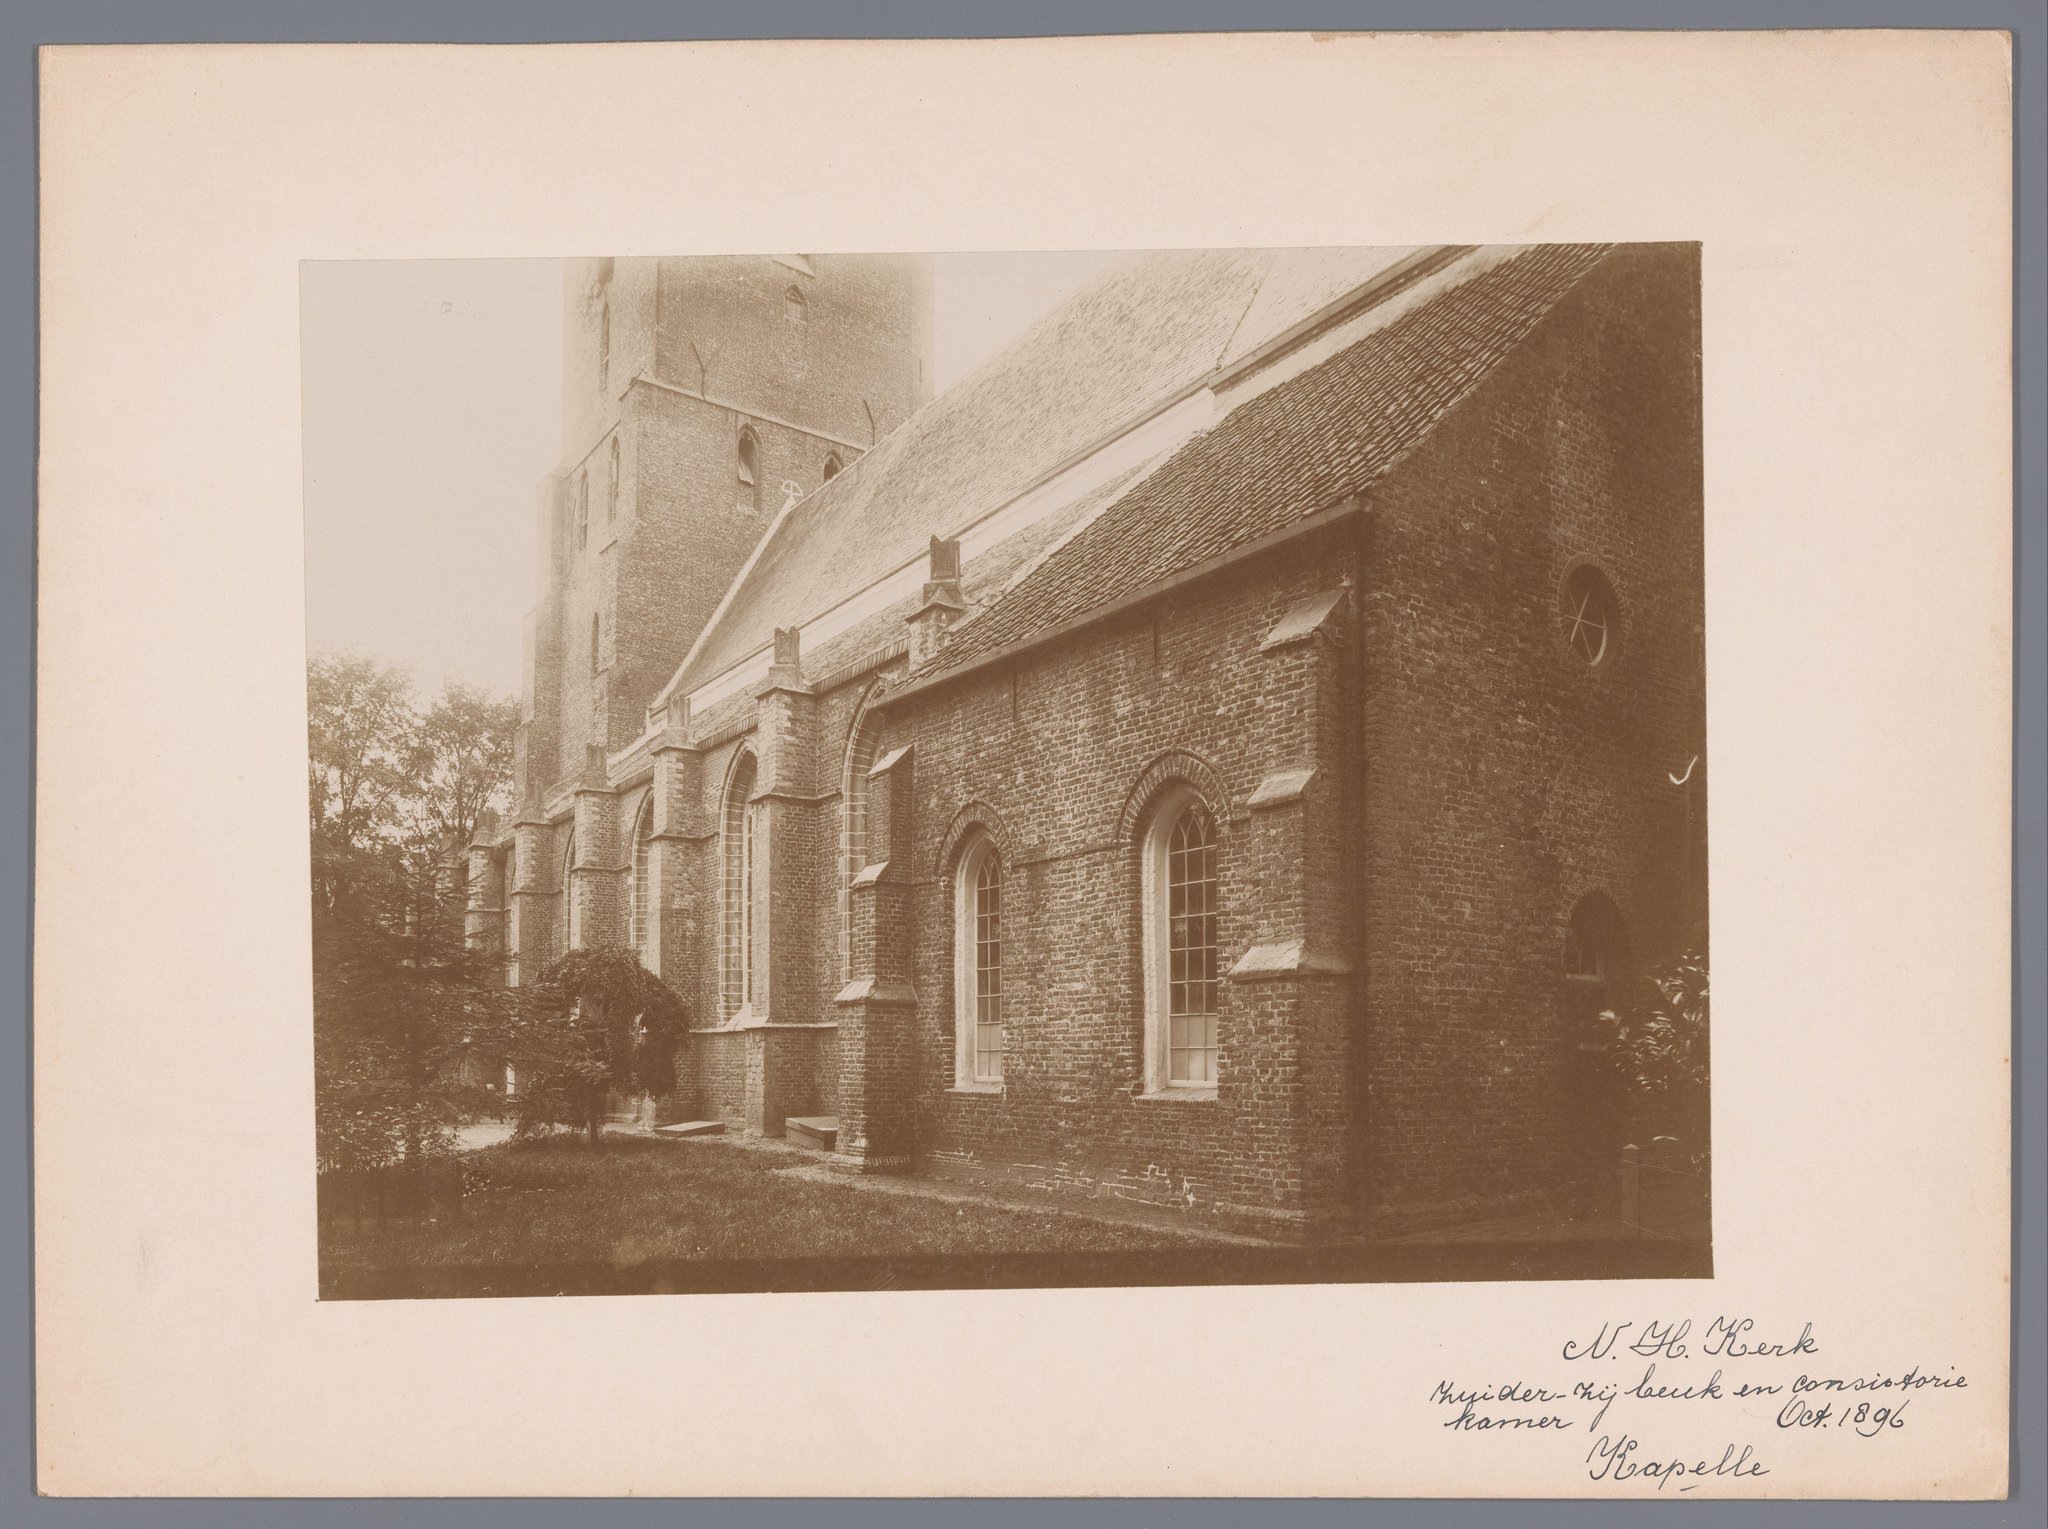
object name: photograph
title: Zuidzijde van de Hervormde Kerk te Kapelle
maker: anoniem (monumentenzorg)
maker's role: fotograaf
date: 1896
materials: cardboard, photographic support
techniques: collodion silver print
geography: kapelle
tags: church (exterior)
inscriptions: annotation: ‘N.H. Kerk/ zuider-zij beuk en consistorie kamer Oct. 1896/ Kapelle’, annotation: ‘Kapelle Z.B. (Zeeland)/ Zuiderzijbeuk en consistorie kamer van de Ned. Herv. Kerk/ oct. 1896’